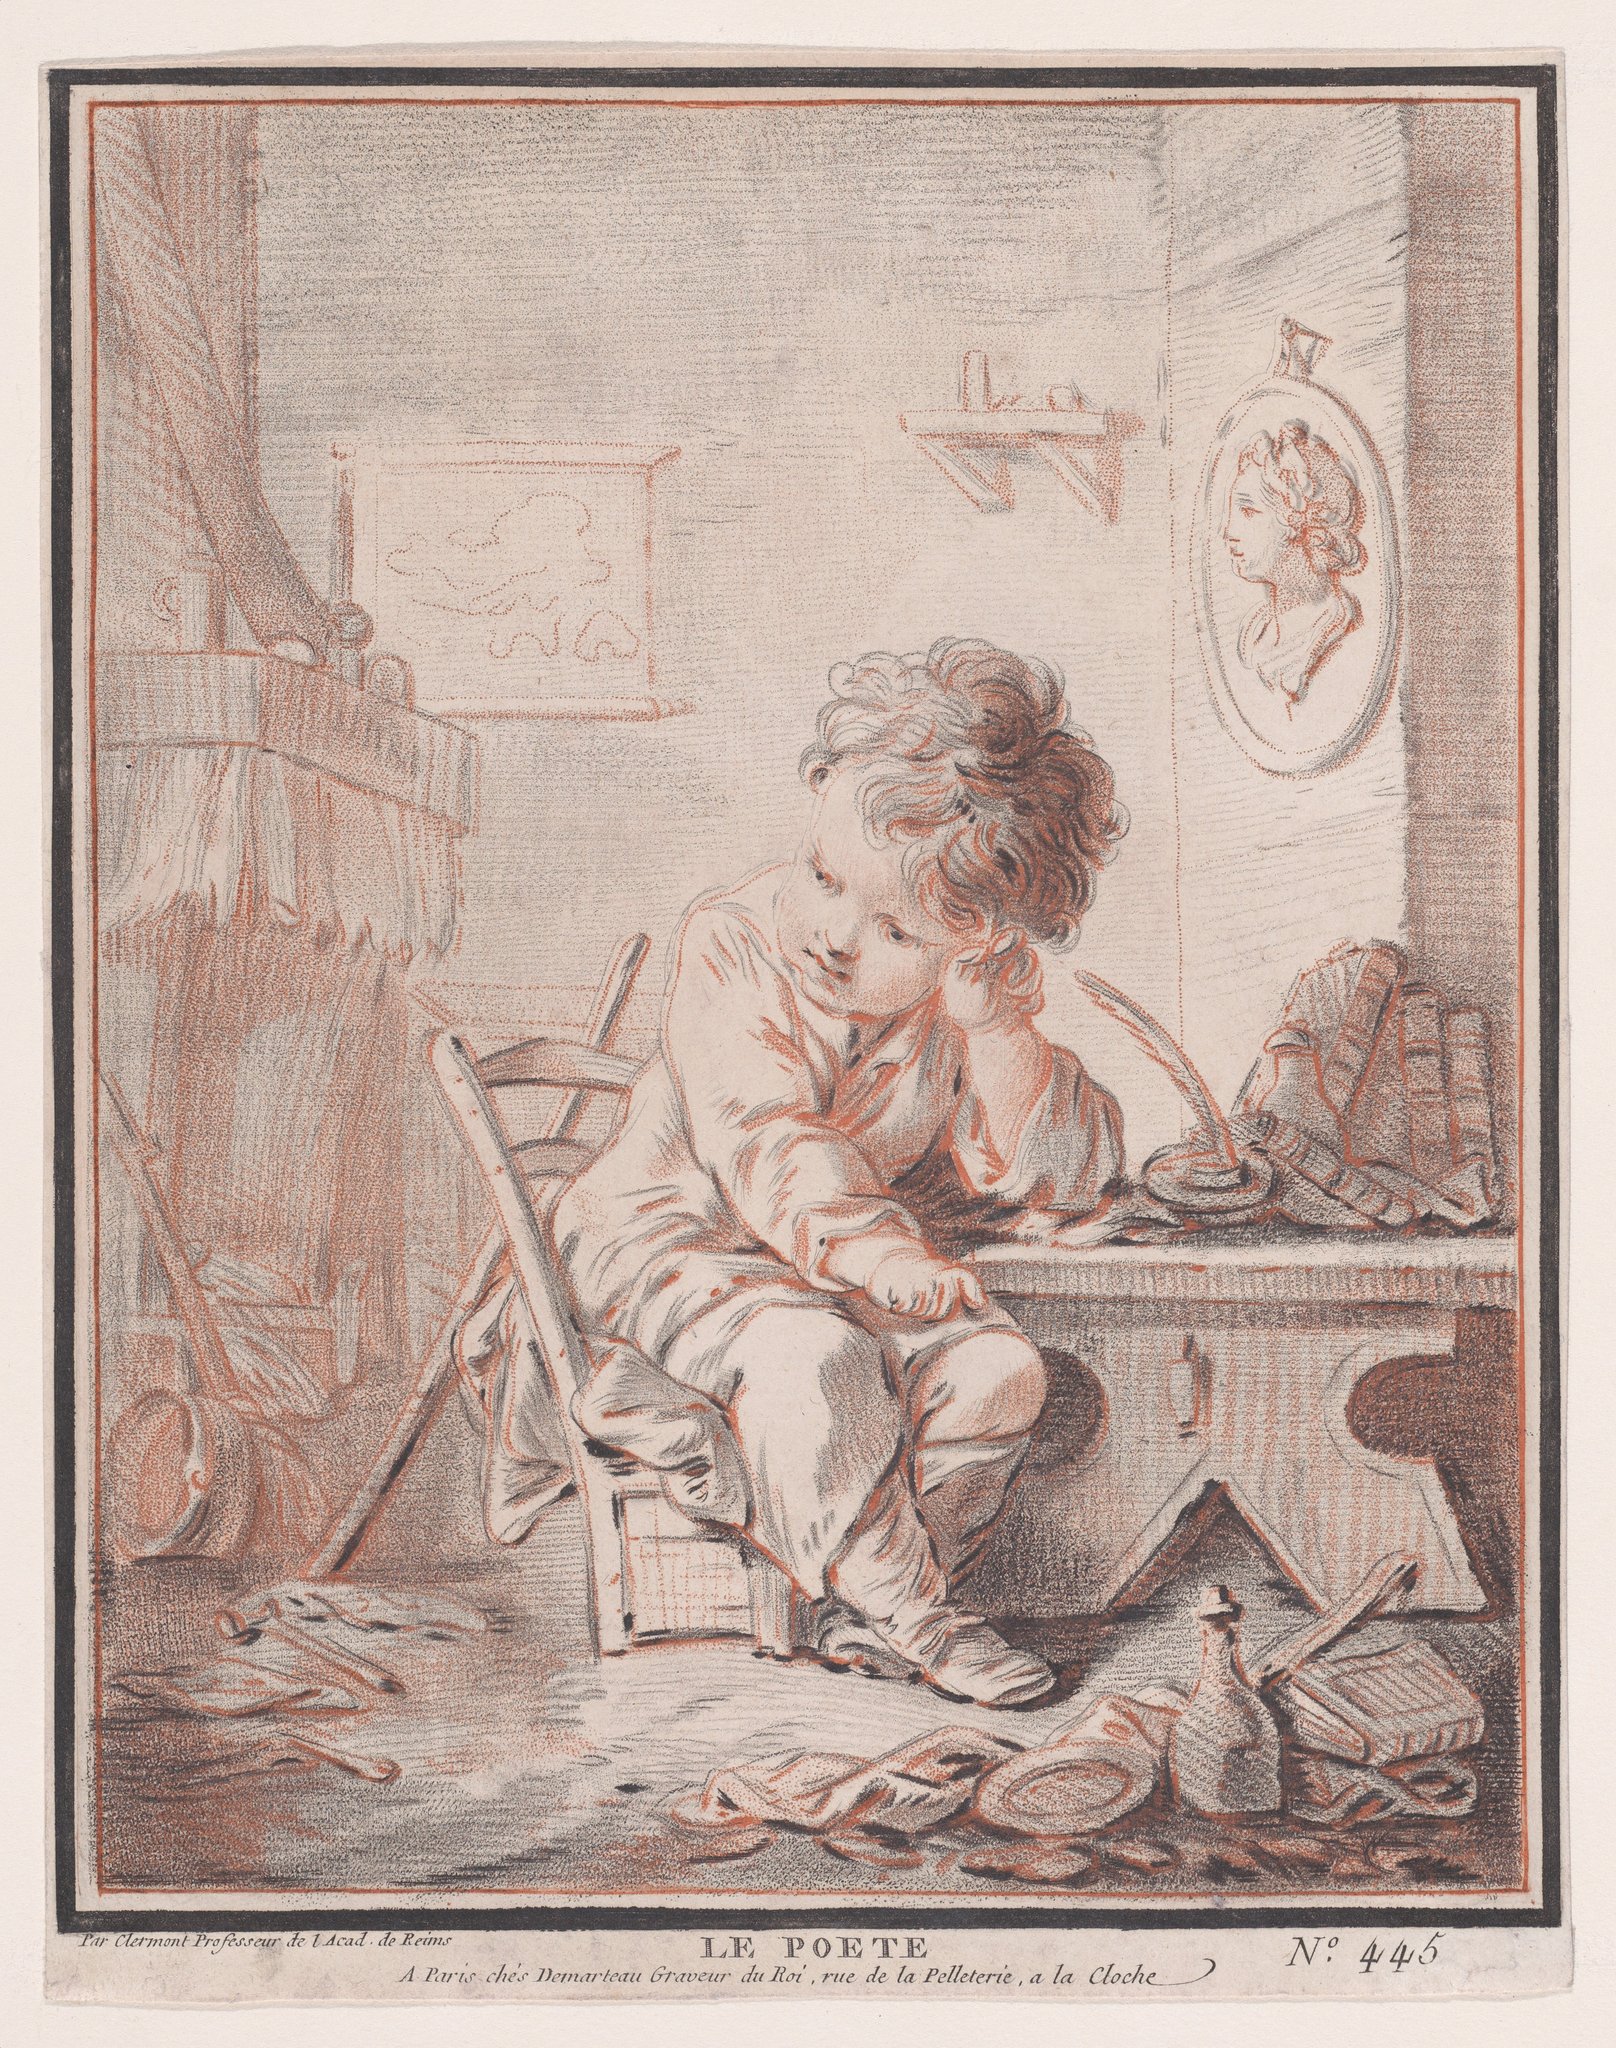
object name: print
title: The Poet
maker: gilles demarteau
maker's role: artist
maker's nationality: french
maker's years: 1722-1776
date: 1701-1800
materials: ink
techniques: printmaking, etching, printing